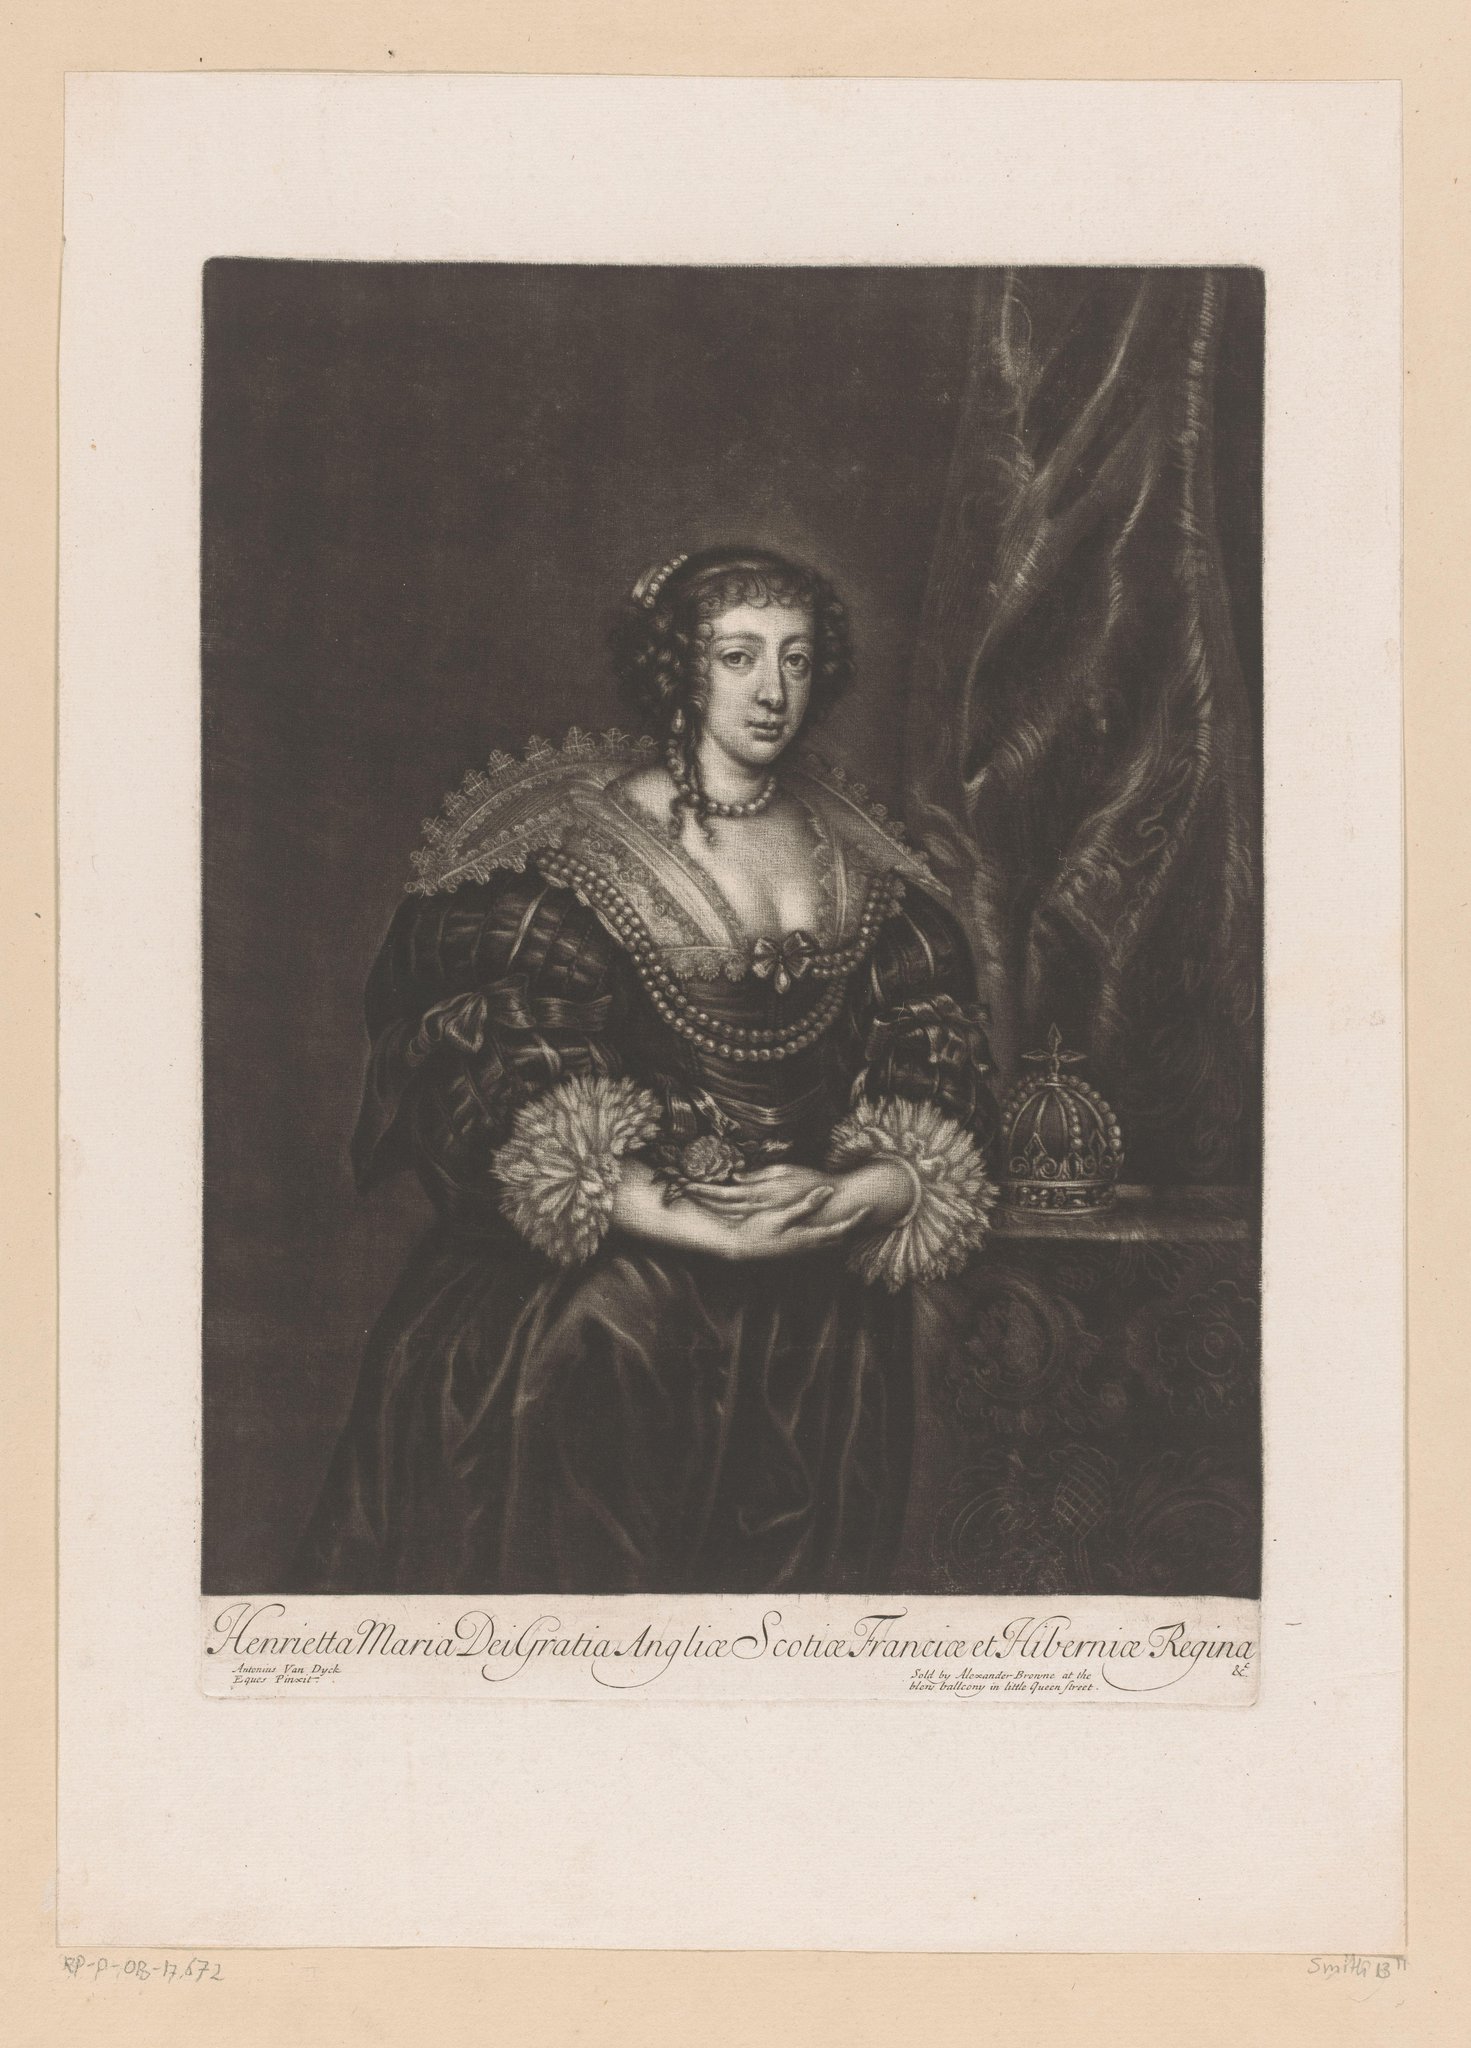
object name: print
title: Henrietta Maria Dei Gratia Angliae Scotiae Franciae et Hiberniae Regina &c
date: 1681-1683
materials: paper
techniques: mezzotint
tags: henriëtta maria van frankrijk (koningin van engeland, schotland en ierland), historical persons, queen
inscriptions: collector's mark: Lugt 240